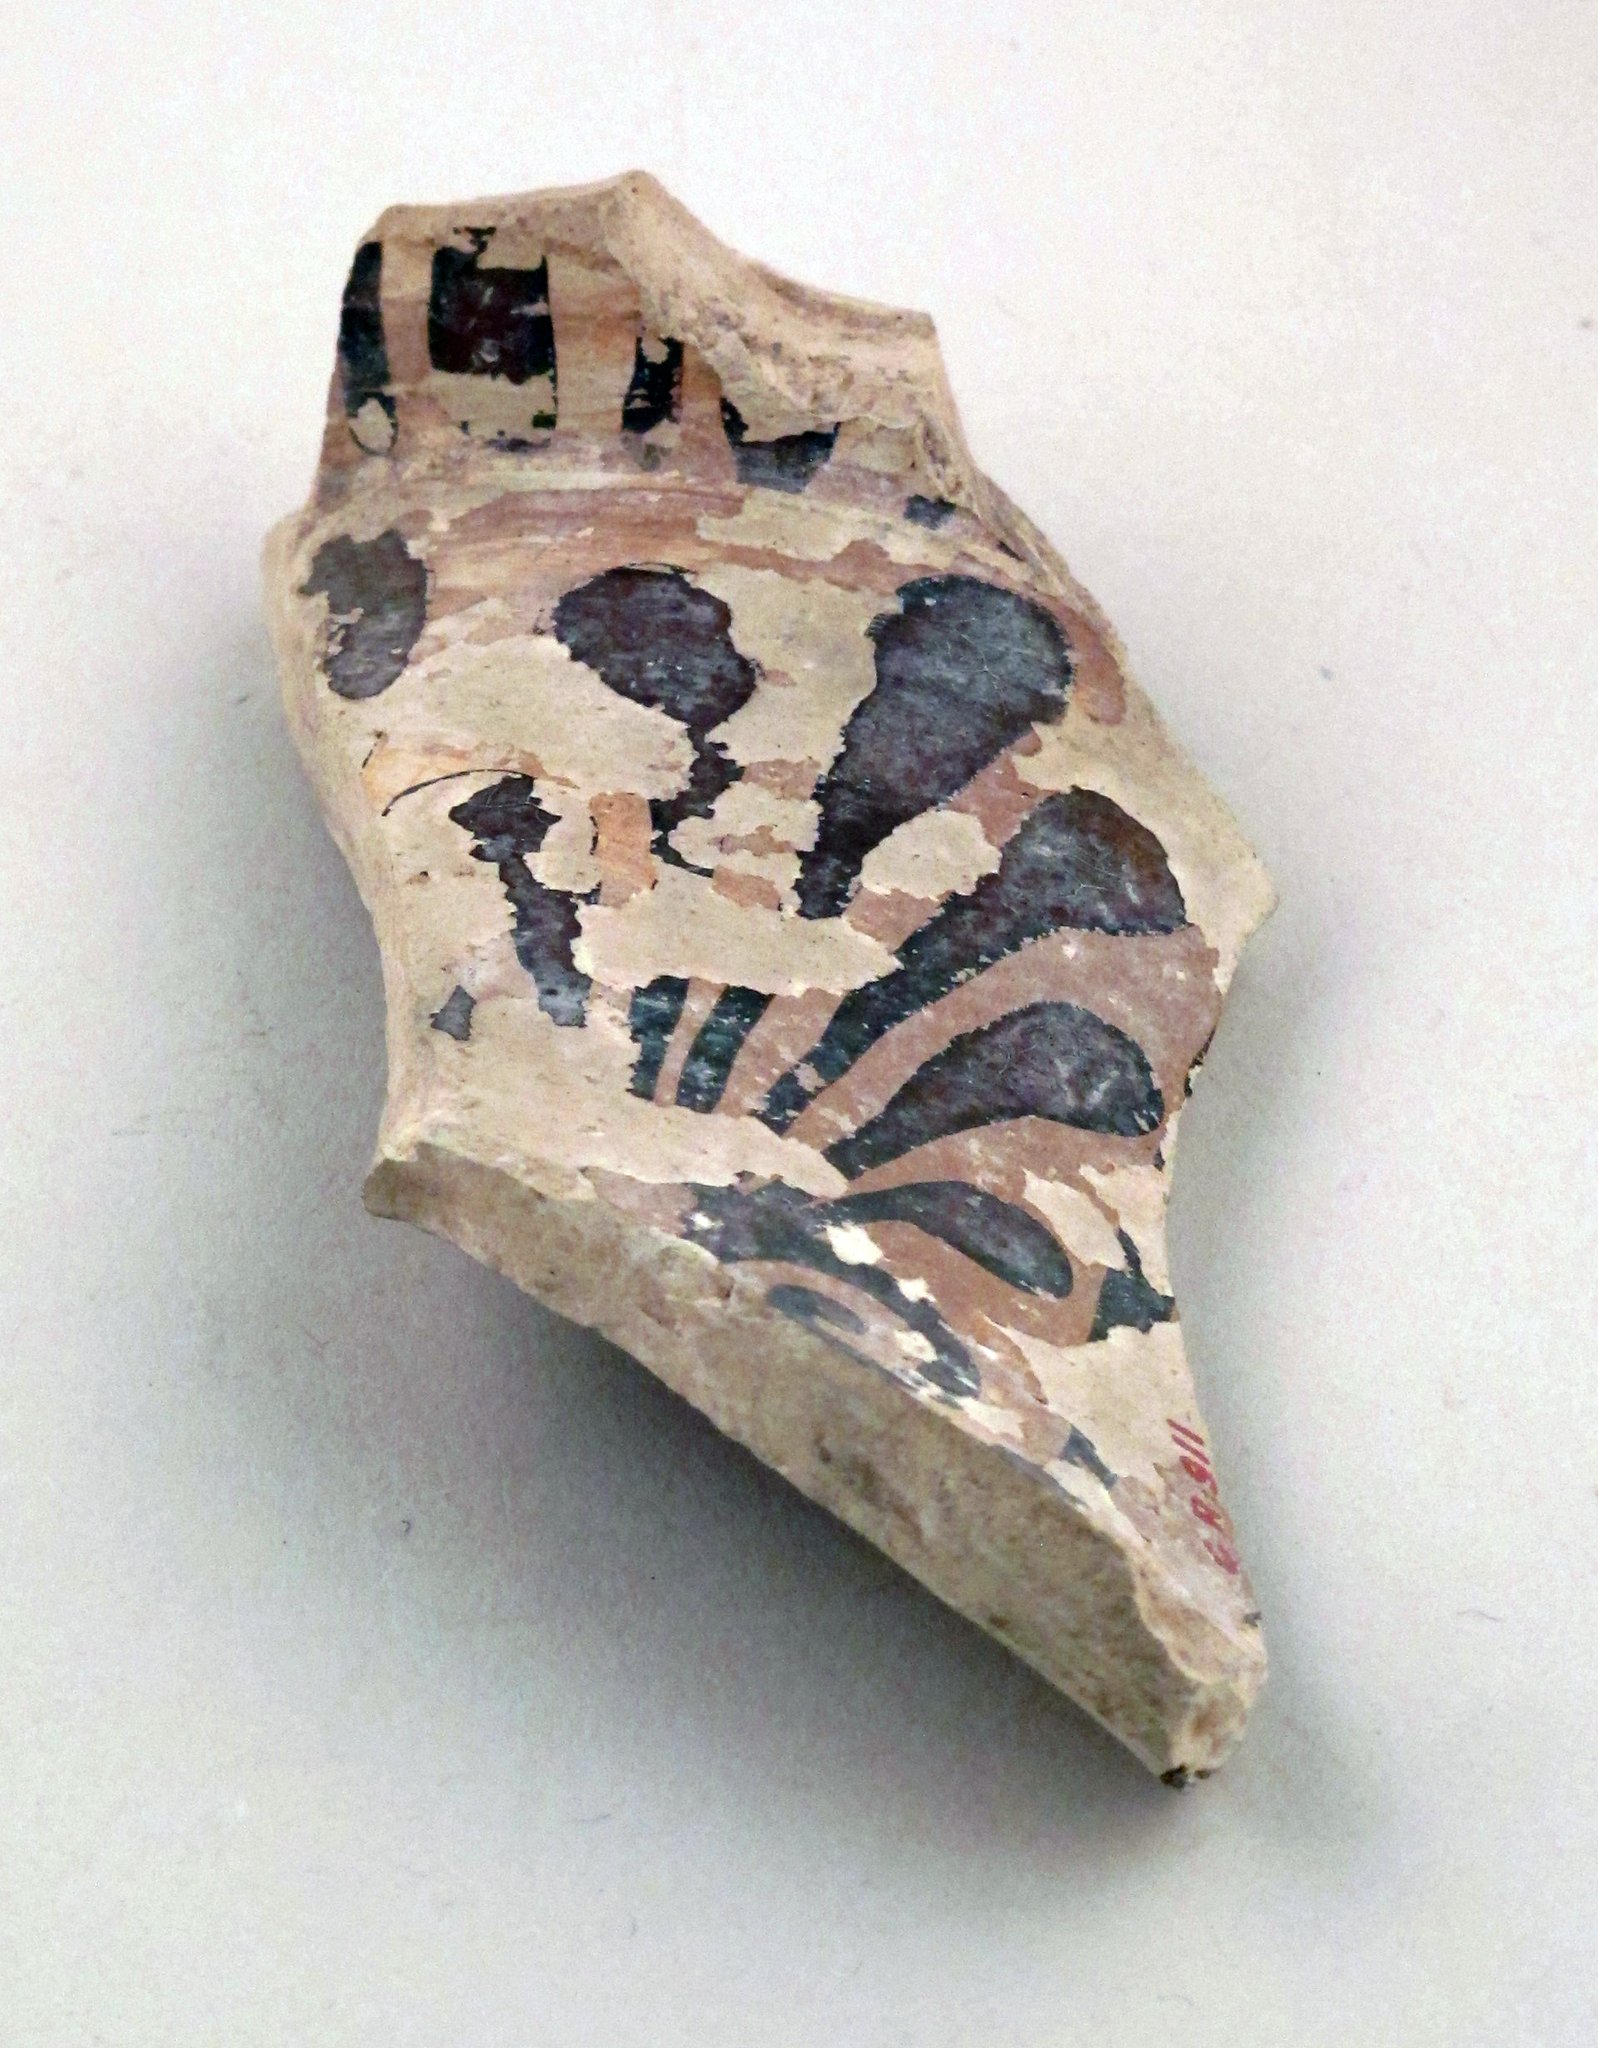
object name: vase fragment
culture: etruscan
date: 534-468 BCE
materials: terracotta